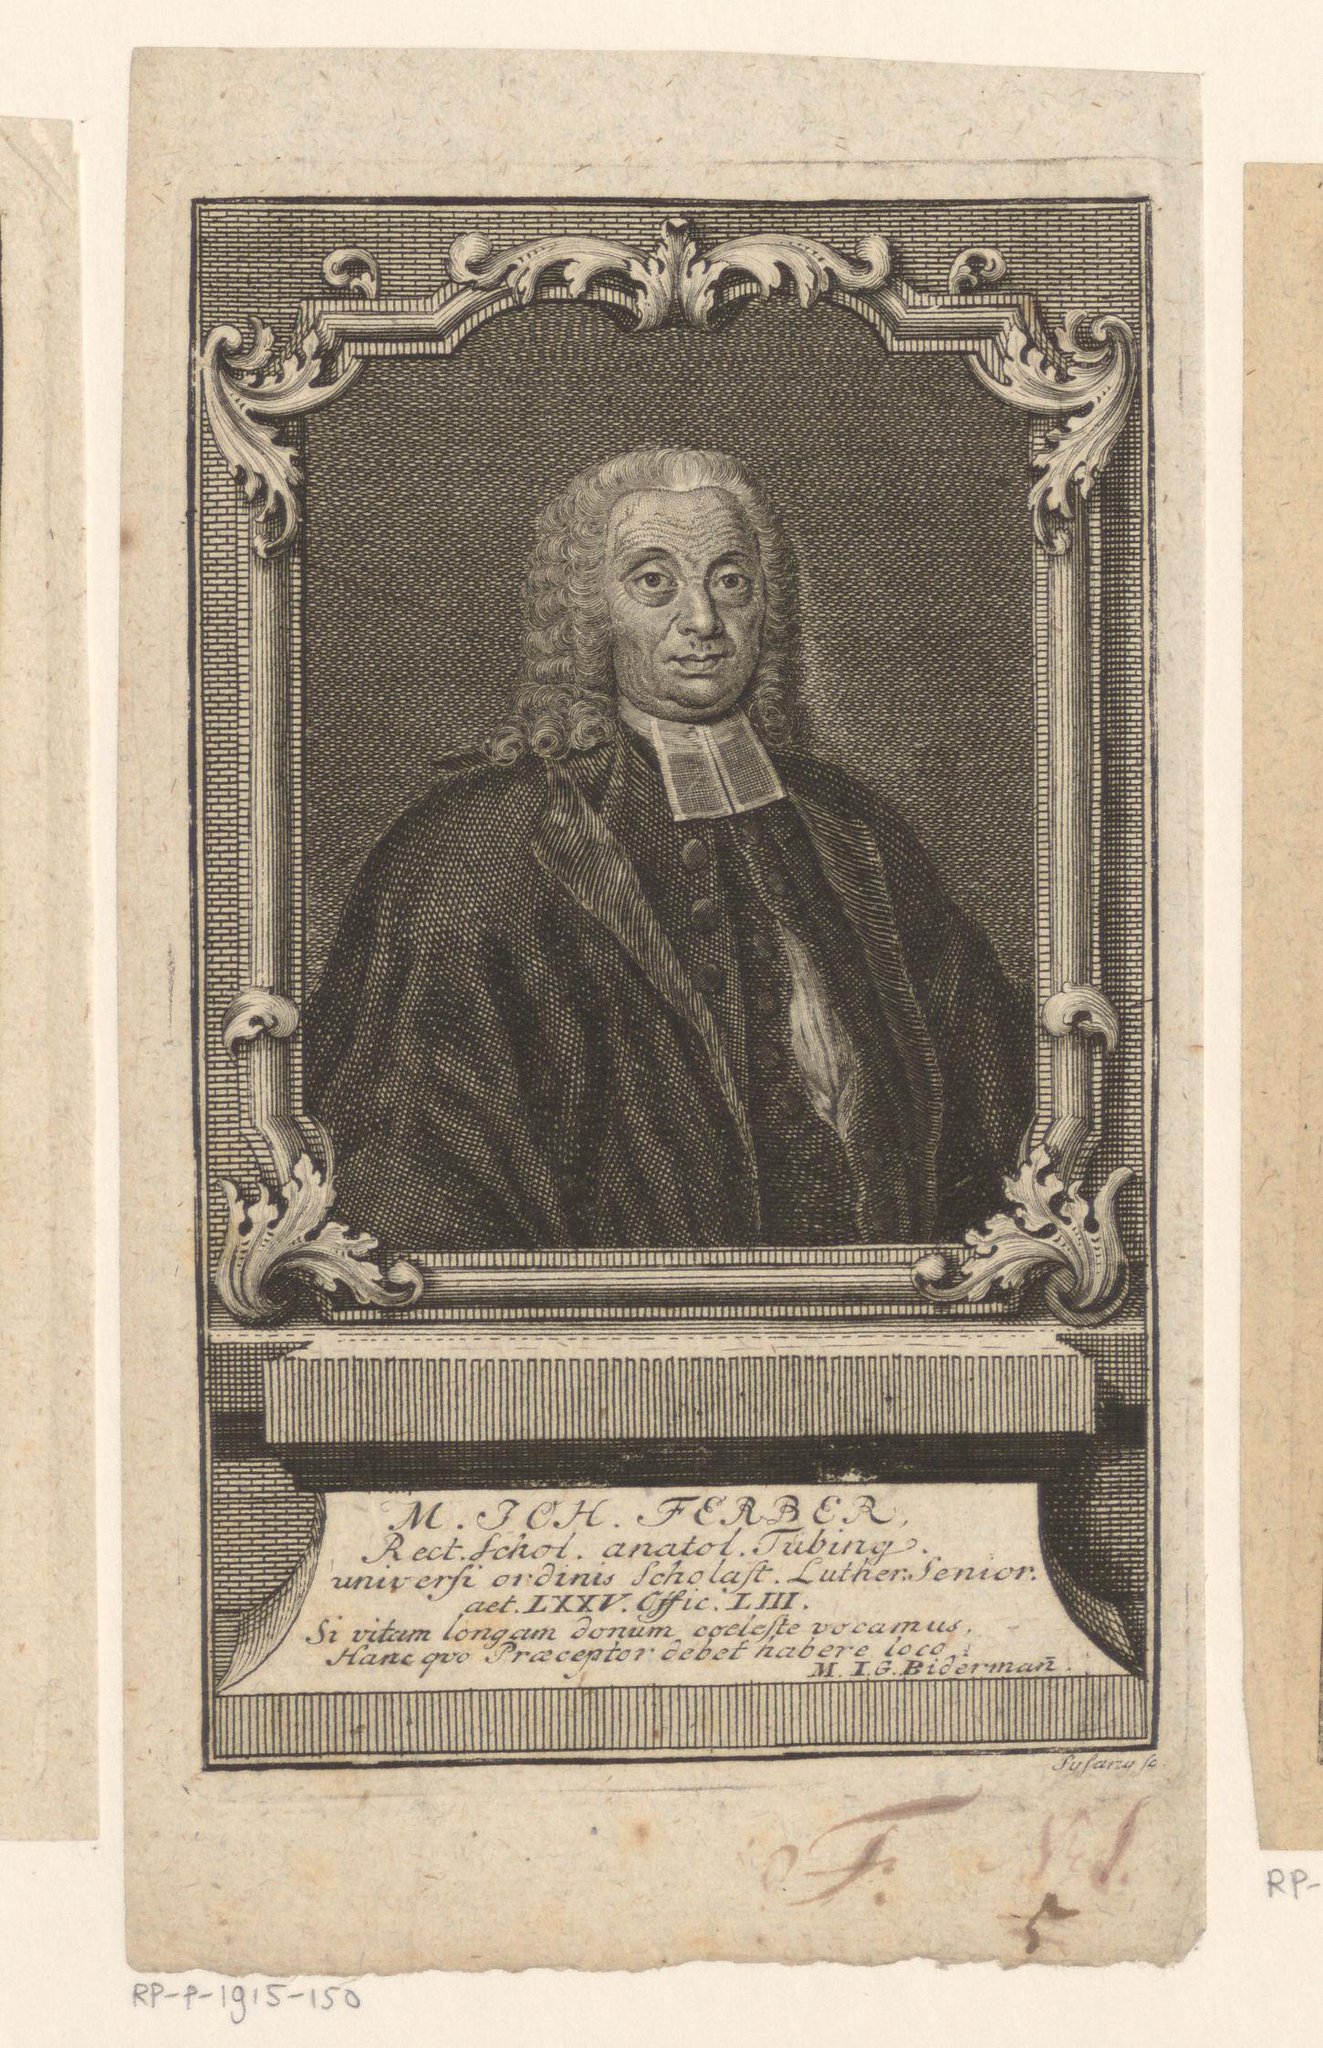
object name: print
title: Portret van Johann Ferber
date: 1749-1757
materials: paper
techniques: engraving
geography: leipzig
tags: historical persons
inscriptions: collector's mark: Lugt 2228